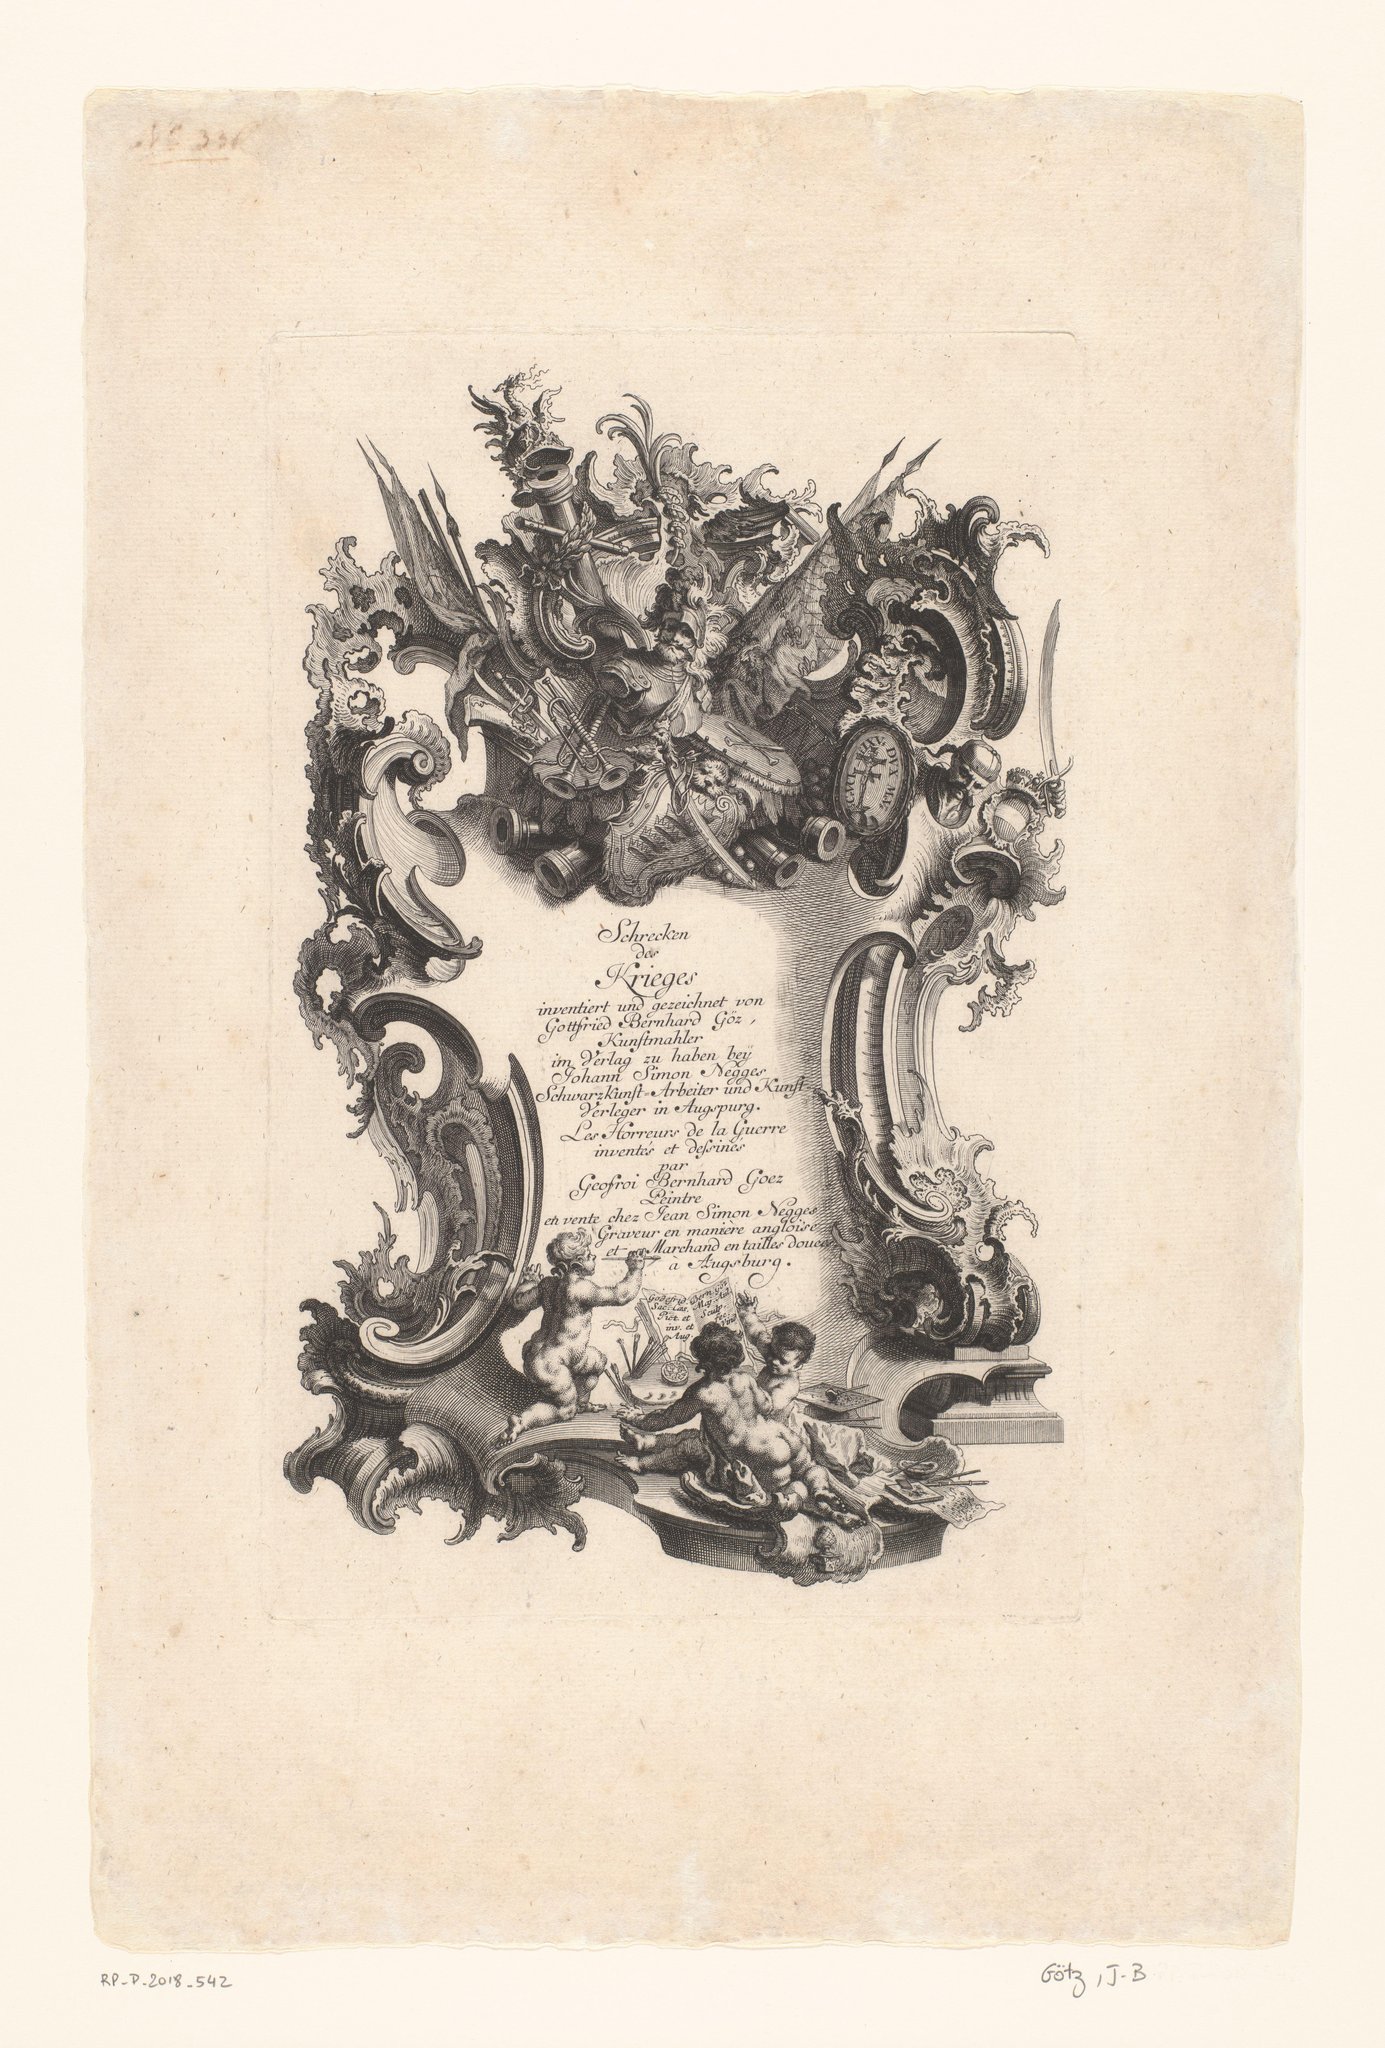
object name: print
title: Schrecken des Krieges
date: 1742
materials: paper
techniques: engraving, etching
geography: augsburg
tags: rocaille ornament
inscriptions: collector's mark: Lugt 2760, collector's mark: Lugt 2228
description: Gegraveerde tekst binnen een rijk versierde lijst. Onderdeel van een serie van zeven prenten (plus titelprent) over de verschrikkingen van de oorlog in ornamentele rococo-lijsten.